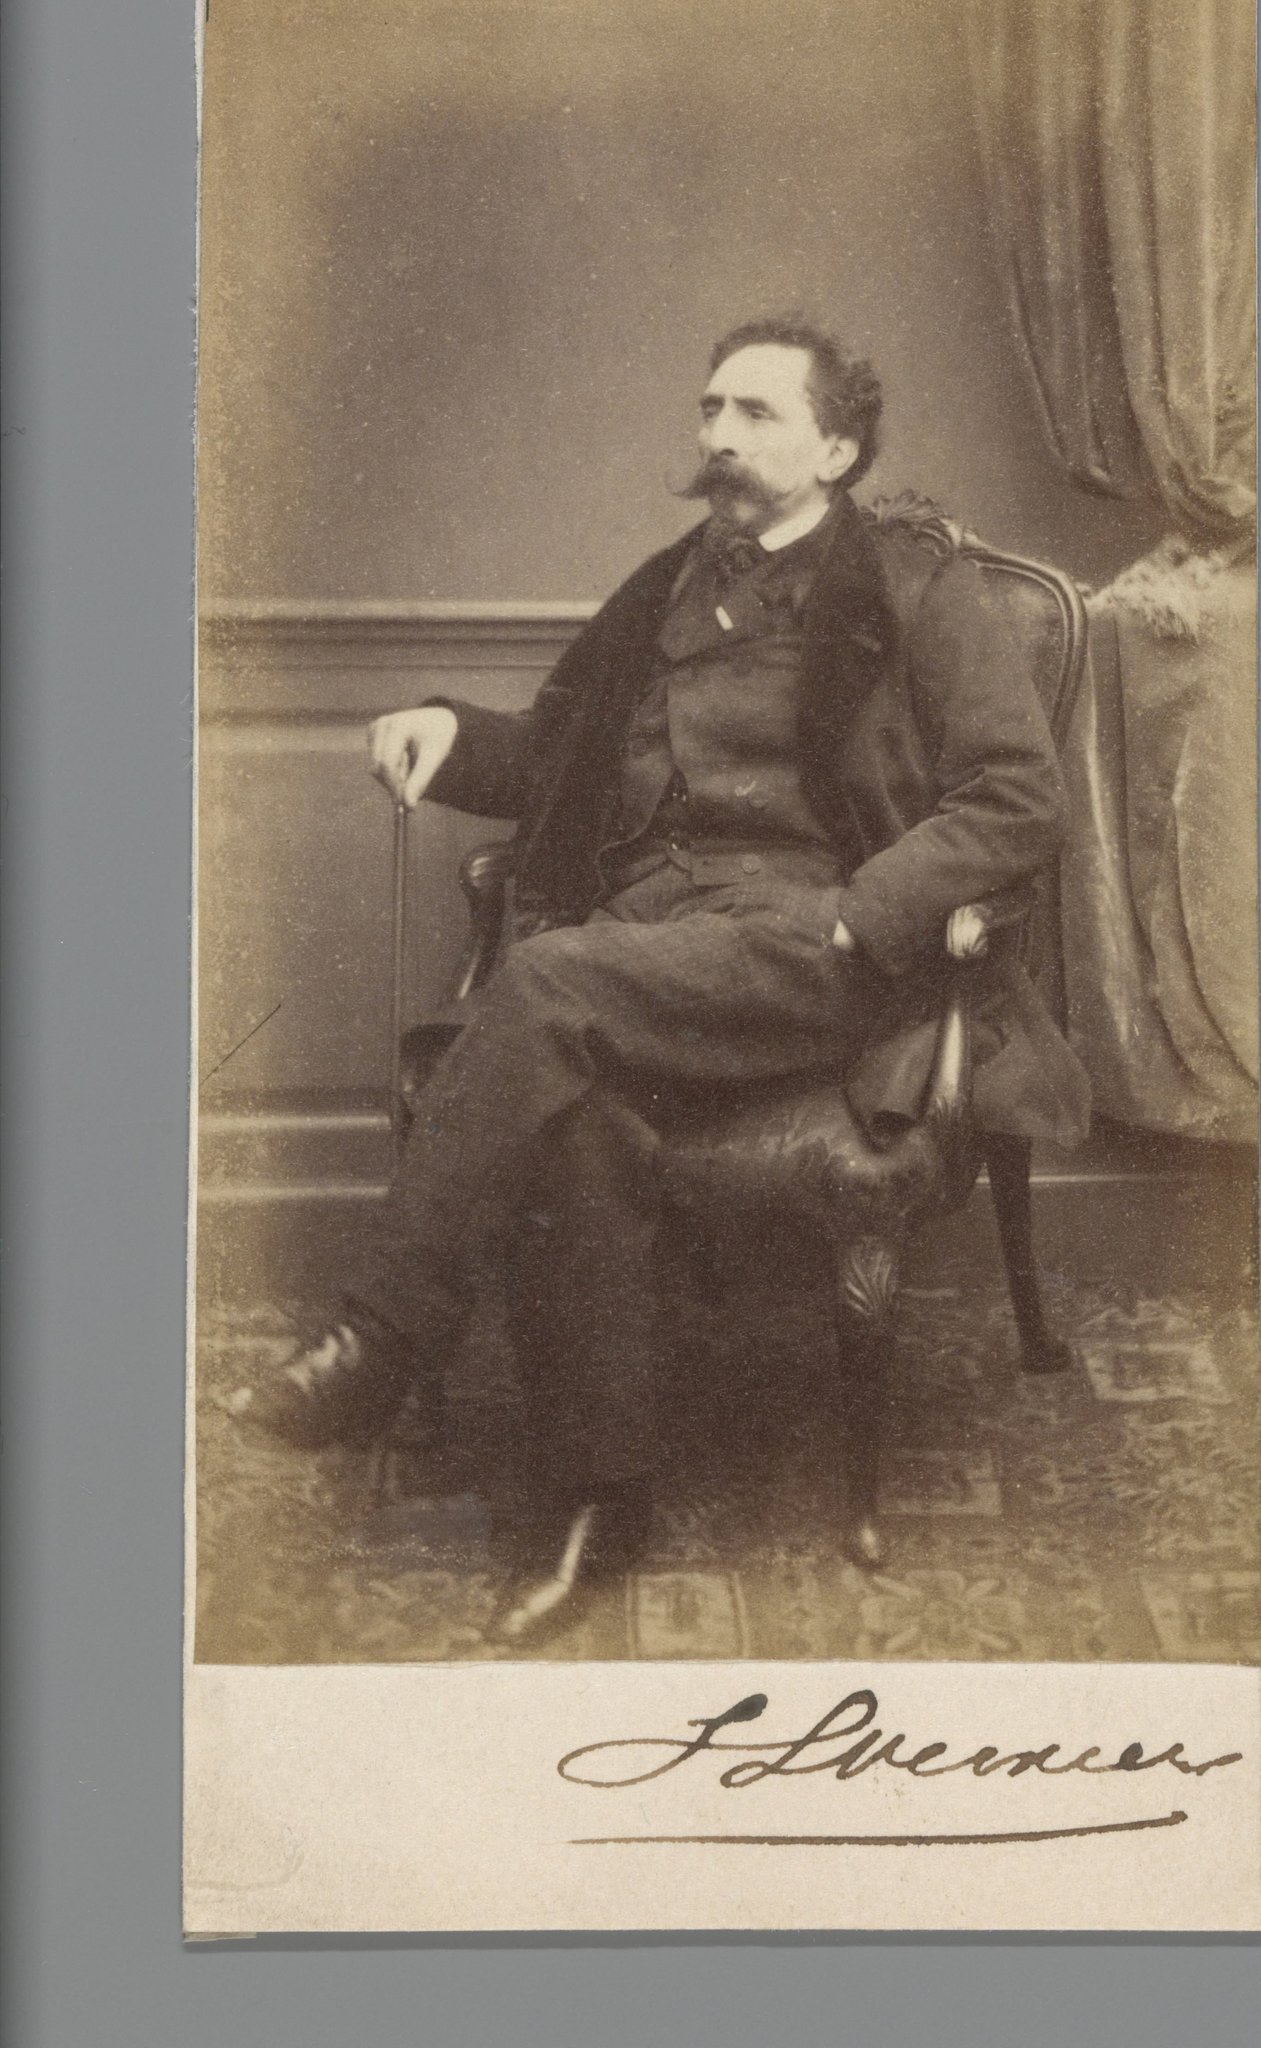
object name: photograph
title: Portret van Salomon Leonardus Verveer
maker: maurits verveer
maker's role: painter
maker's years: 1817-1903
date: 1861-1876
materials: cardboard, paper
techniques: albumen print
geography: the hague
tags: the hague, salomon leonardus verveer, historical persons, portrait, self-portrait of painter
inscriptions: signature: ‘SL Verveer’, inscription: ‘Sam L. Ve/ Sam L. Verveer’